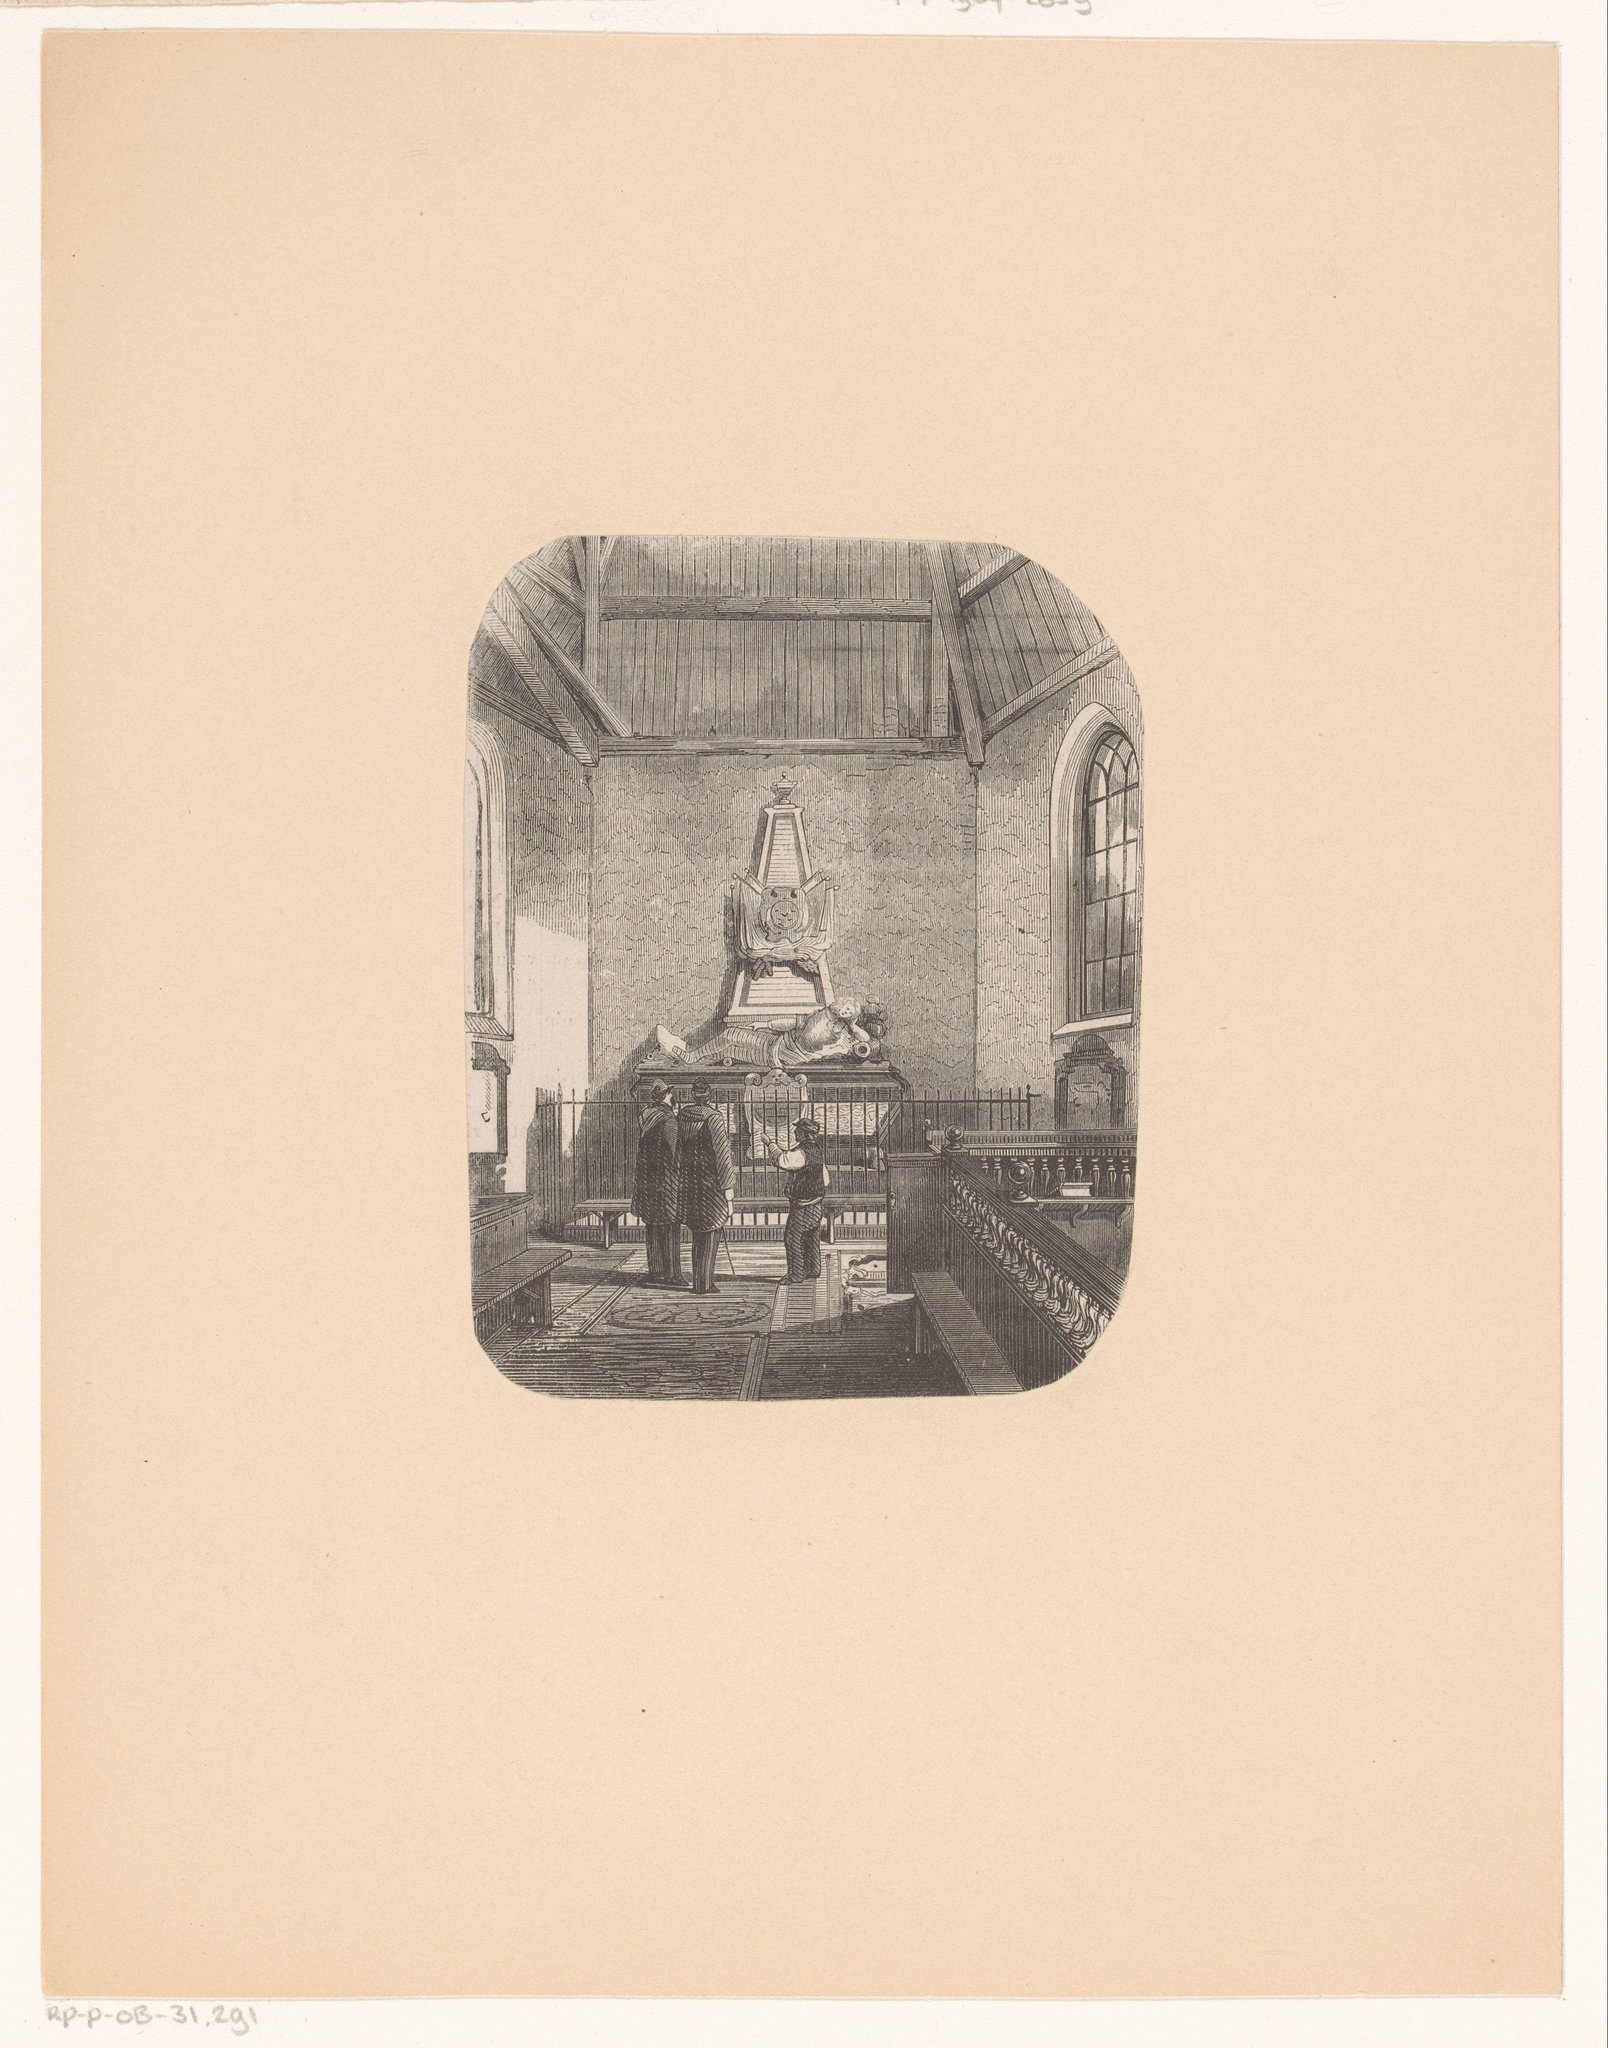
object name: print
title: Grafmonument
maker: Anonymous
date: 1800-1899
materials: paper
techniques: engraving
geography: netherlands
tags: interior of church, grave-building, monumental tomb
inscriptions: collector's mark: Lugt 2228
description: Drie mannen staan voor een grafmonument in een kerk.